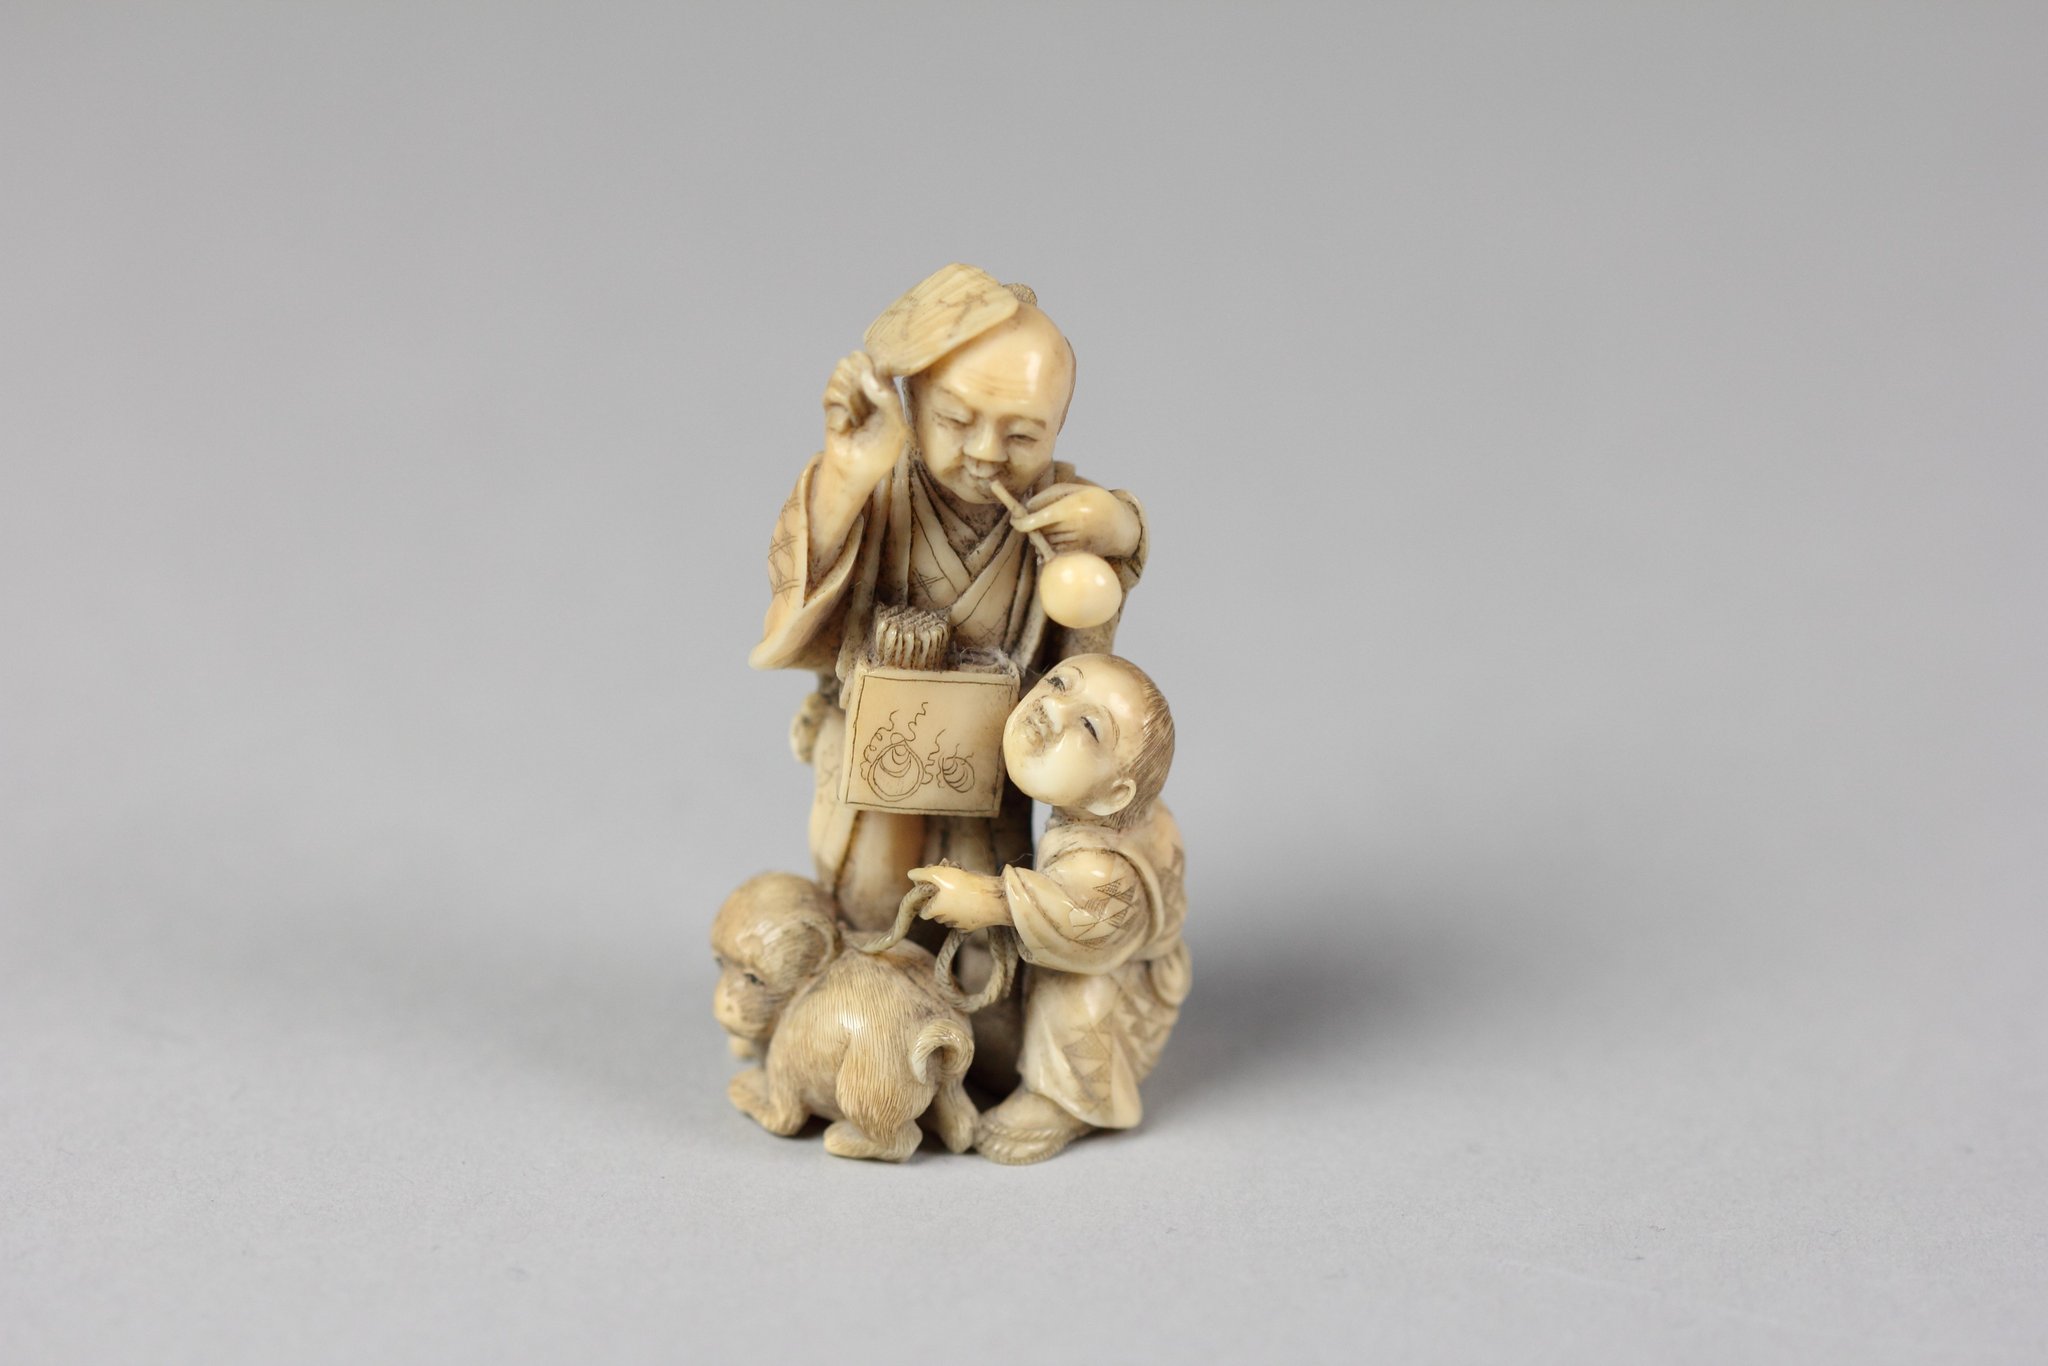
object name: netsuke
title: Netsuke of Group of Figures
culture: japanese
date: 1801-1900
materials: ivory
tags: boys,monkeys